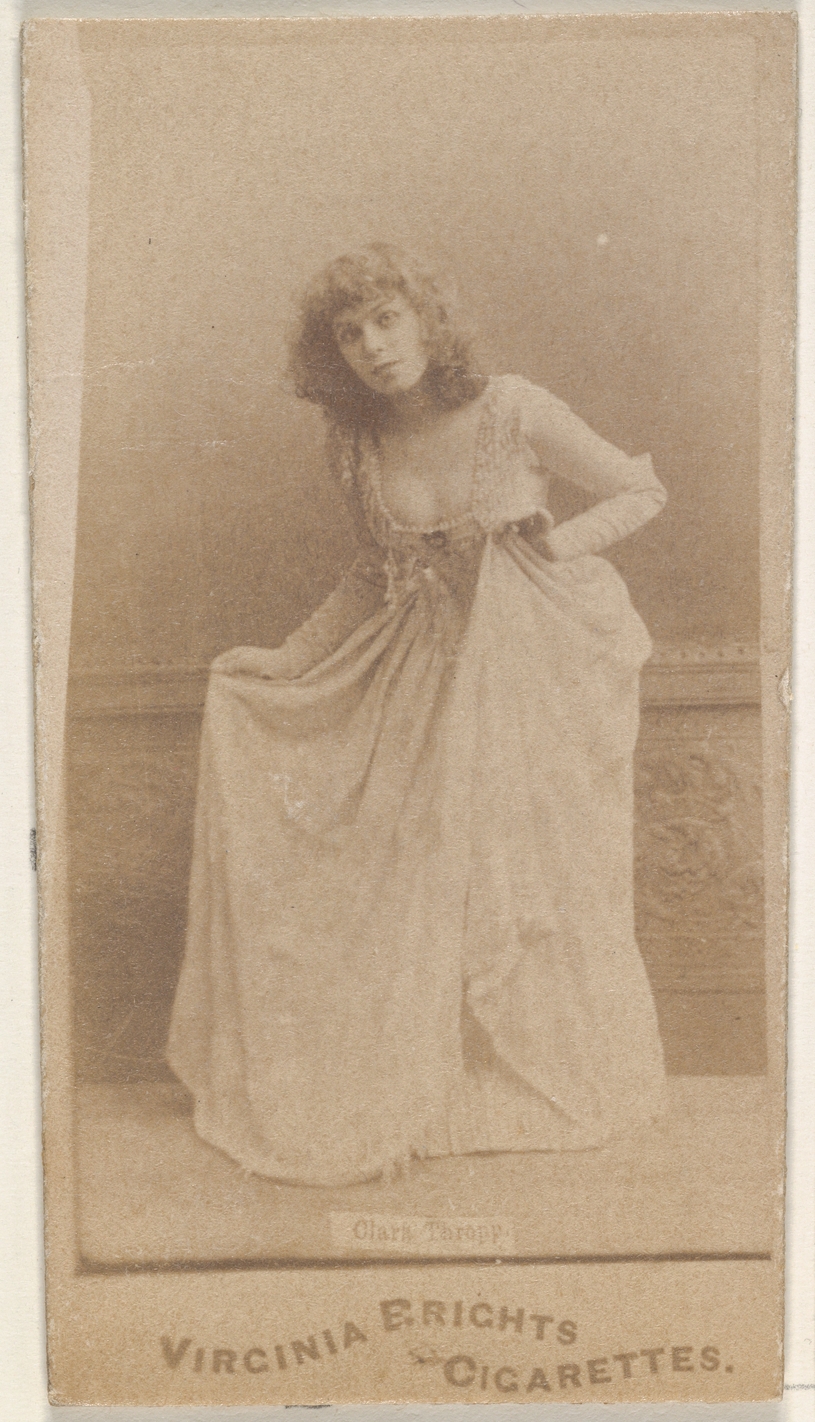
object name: photograph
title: Clara Thropp, from the Actors and Actresses series (N45, Type 1) for Virginia Brights Cigarettes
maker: allen & ginter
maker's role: publisher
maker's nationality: american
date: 1888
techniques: albumen silver print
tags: portraits,women,actresses